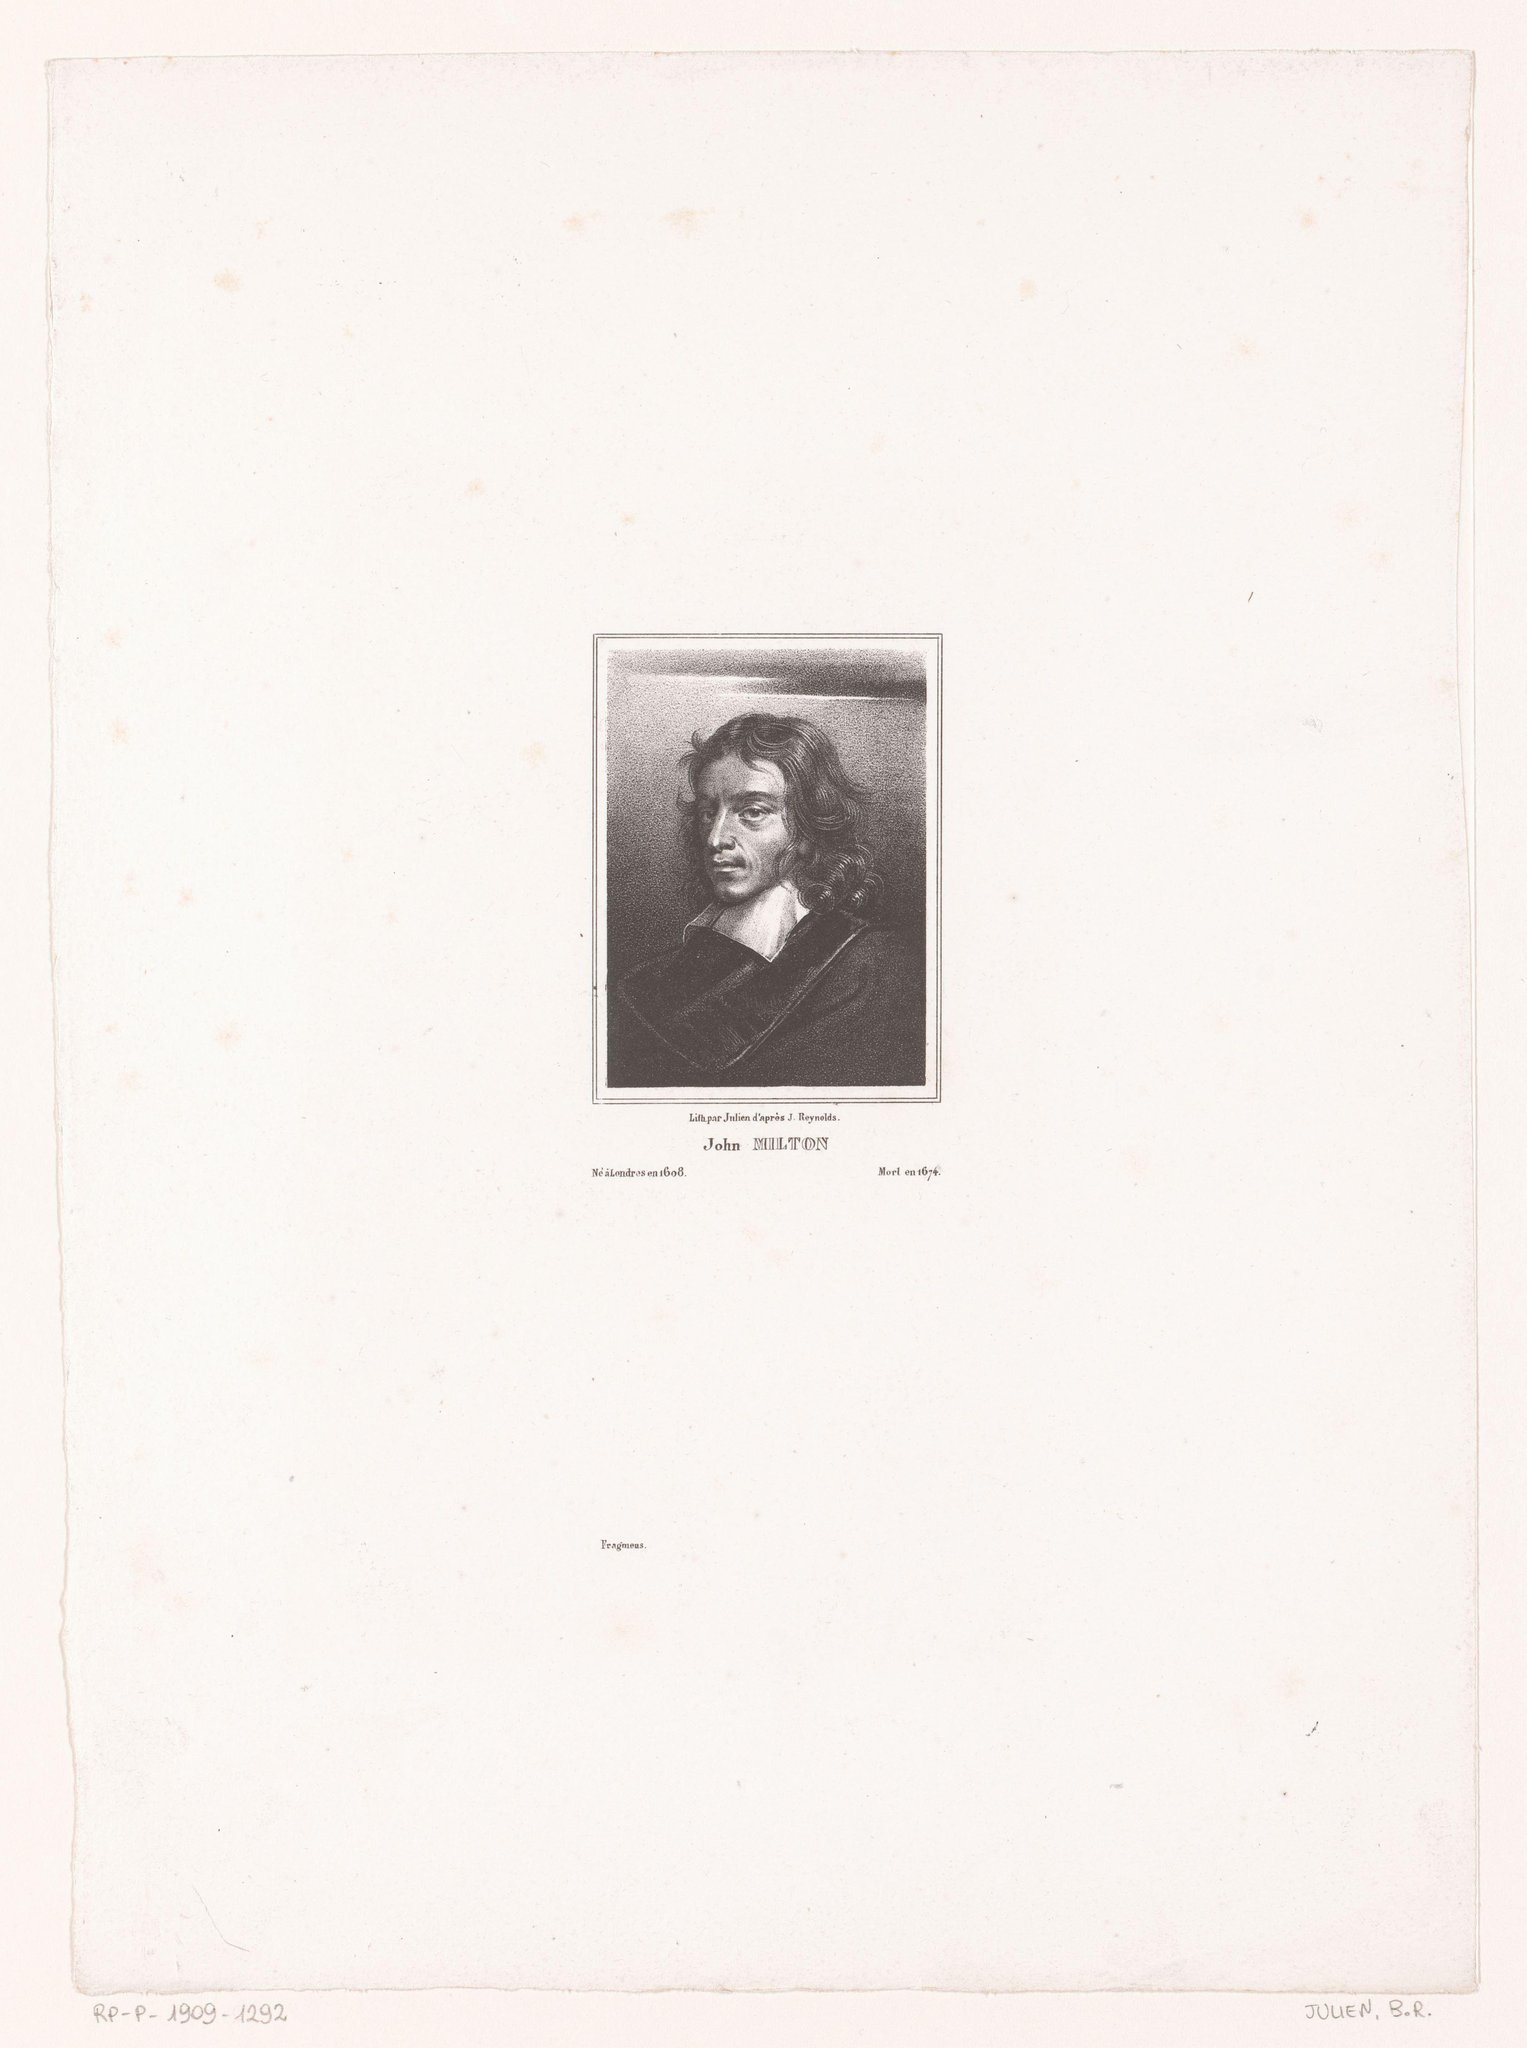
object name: print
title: Portret van John Milton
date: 1830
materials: paper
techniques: lithograph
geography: paris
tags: london, john milton, historical persons, portrait of a writer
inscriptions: collector's mark: Lugt 2228a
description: Prent gebruikt voor: Illustrations du Cours de Littérature de la Harpe, ou collection de 400 portraits destinés à l'ornement de cet ouvrage. Parijs: Boblet, 1830.